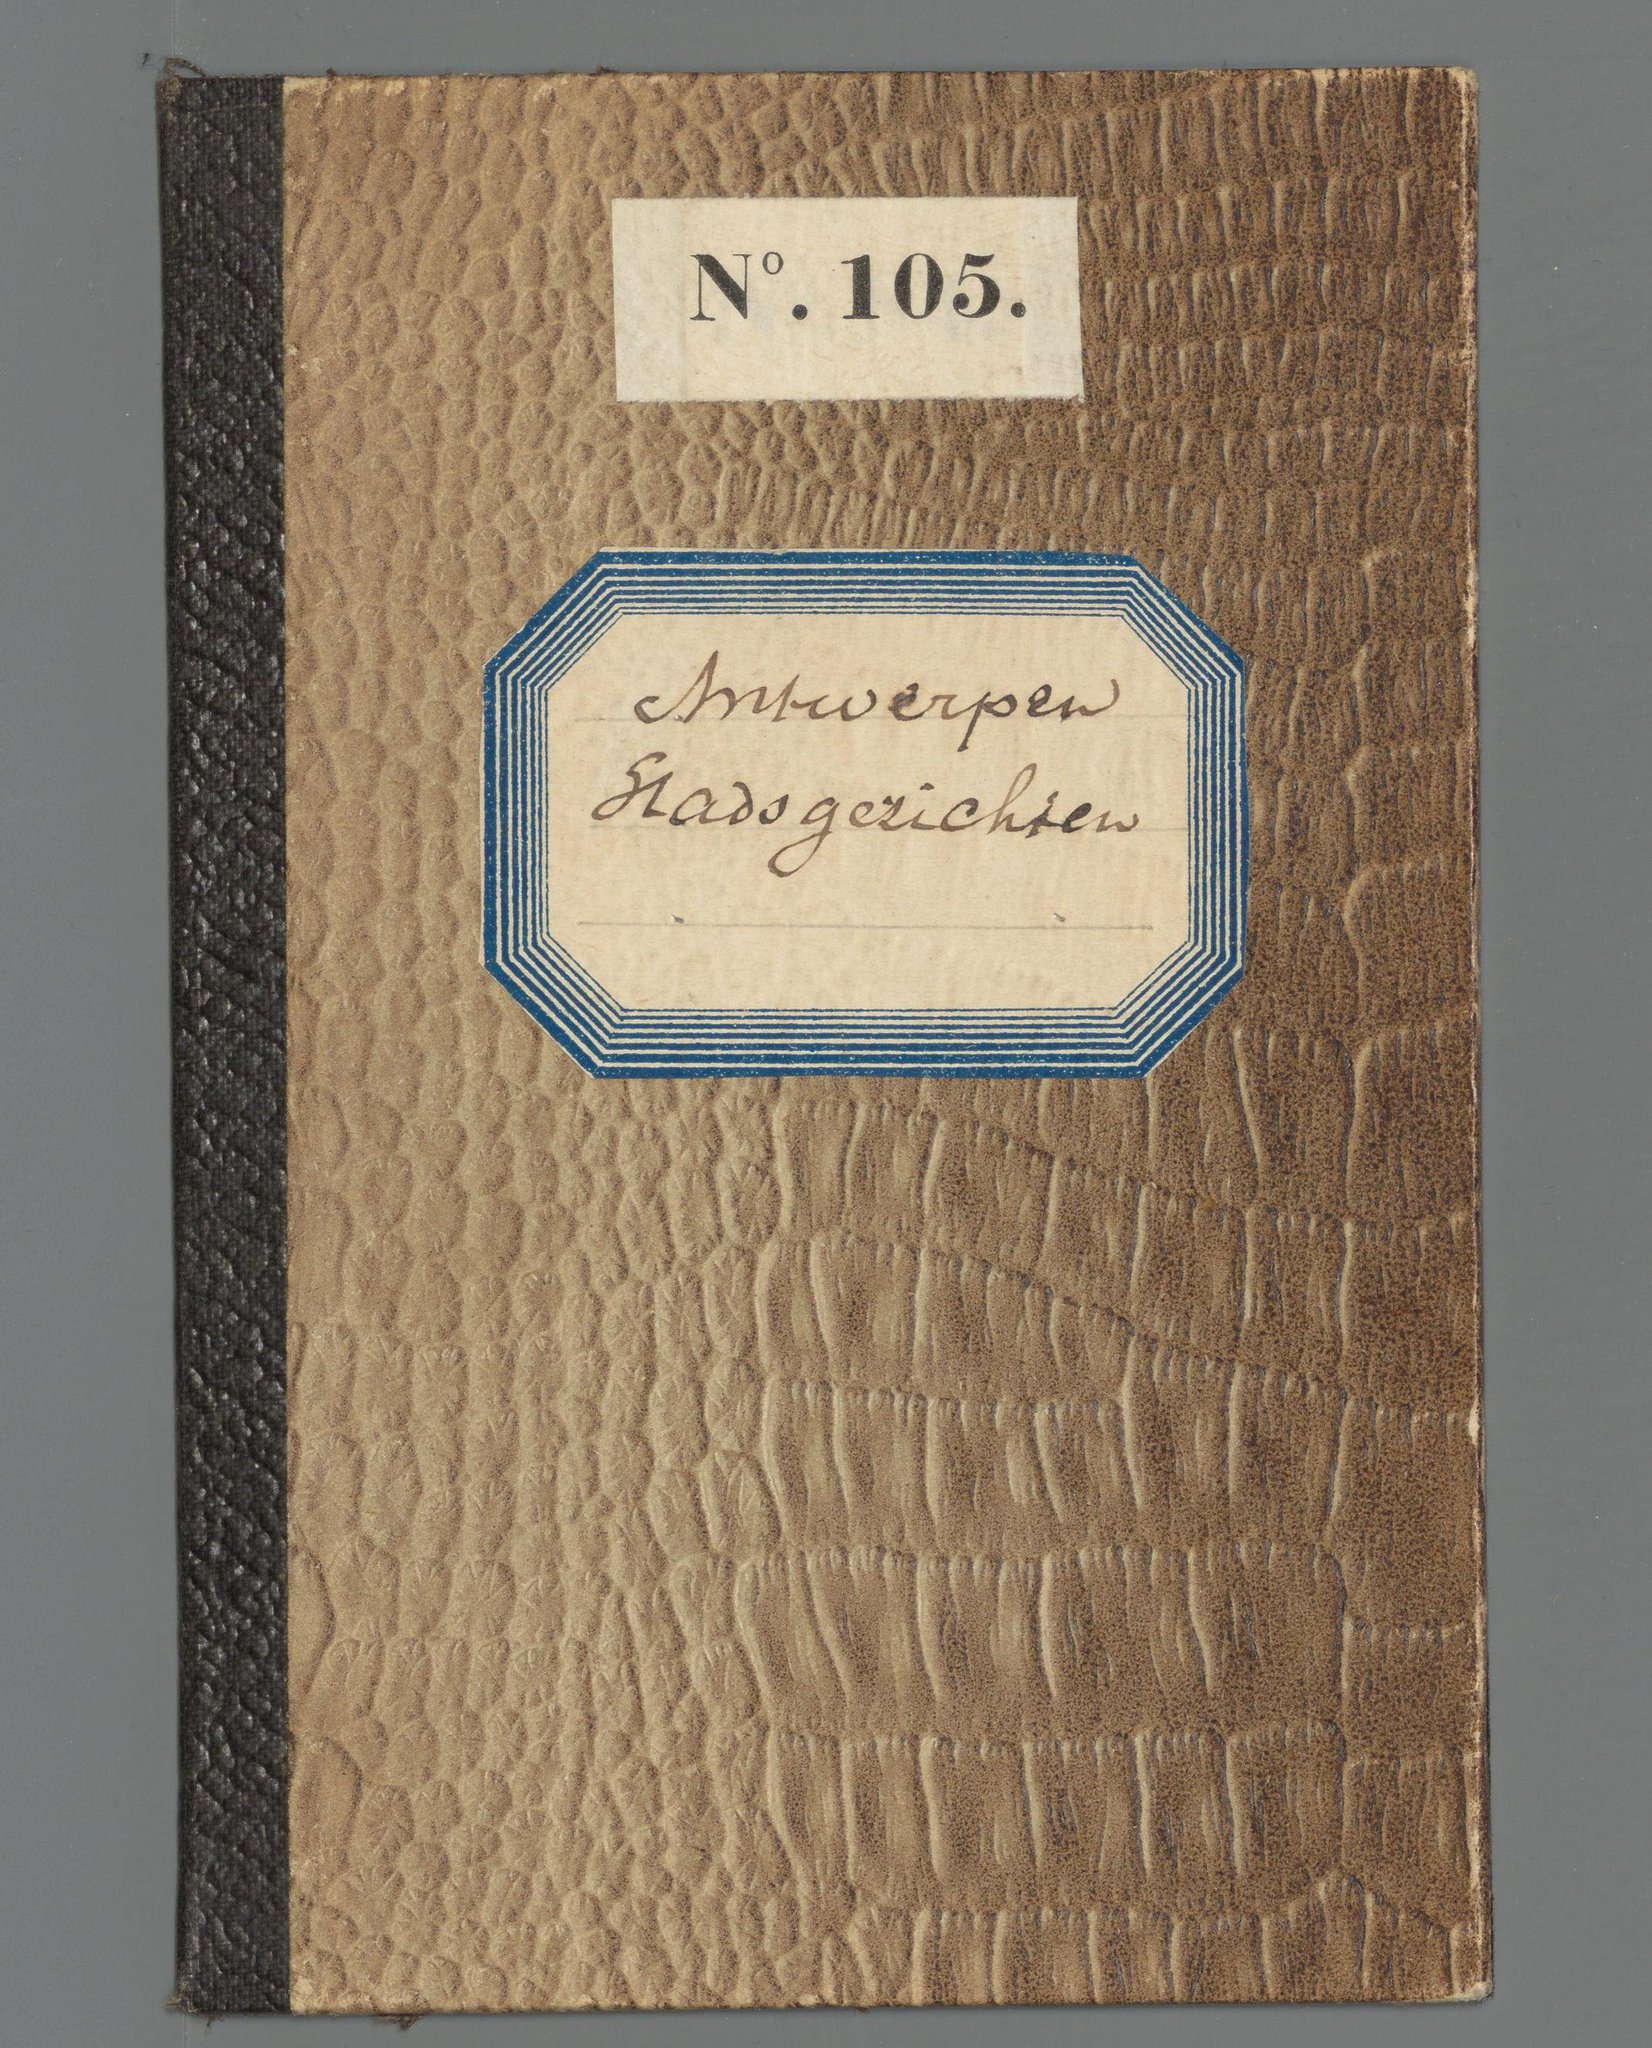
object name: wrapper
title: Omslag voor dertig prentbriefkaarten van Antwerpen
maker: Anonymous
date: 1900-1950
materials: cardboard, ink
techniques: pen